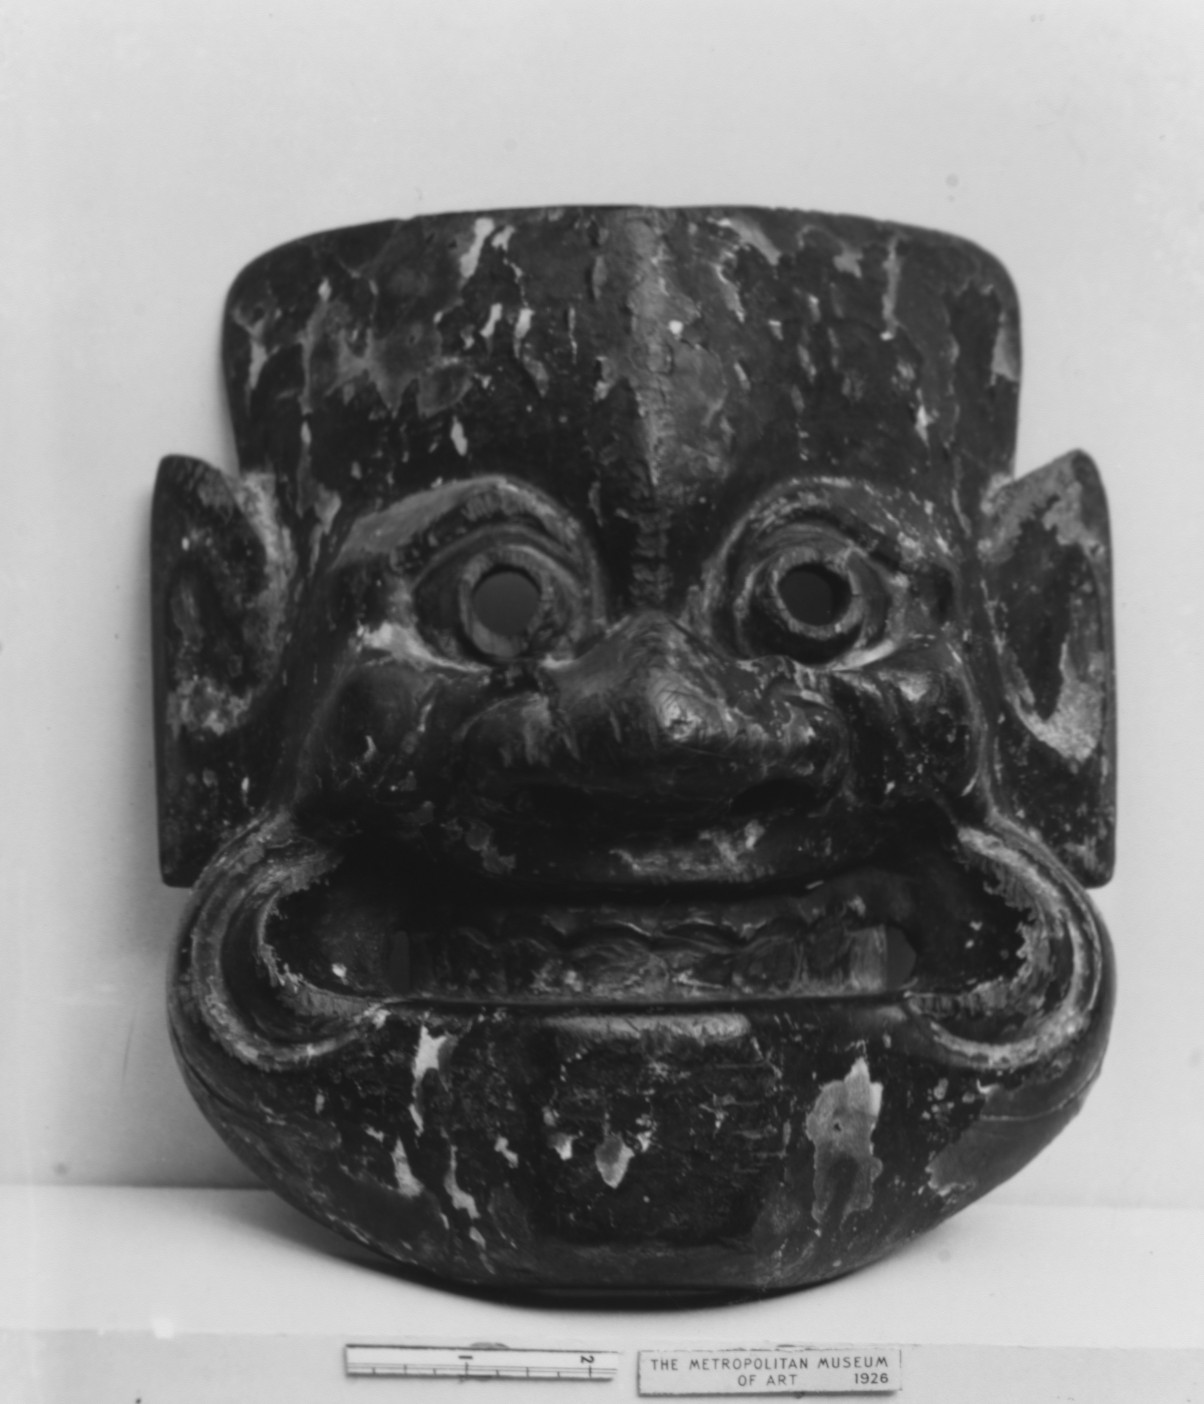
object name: bugaku mask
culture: japanese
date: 1535-1538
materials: wood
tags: masks